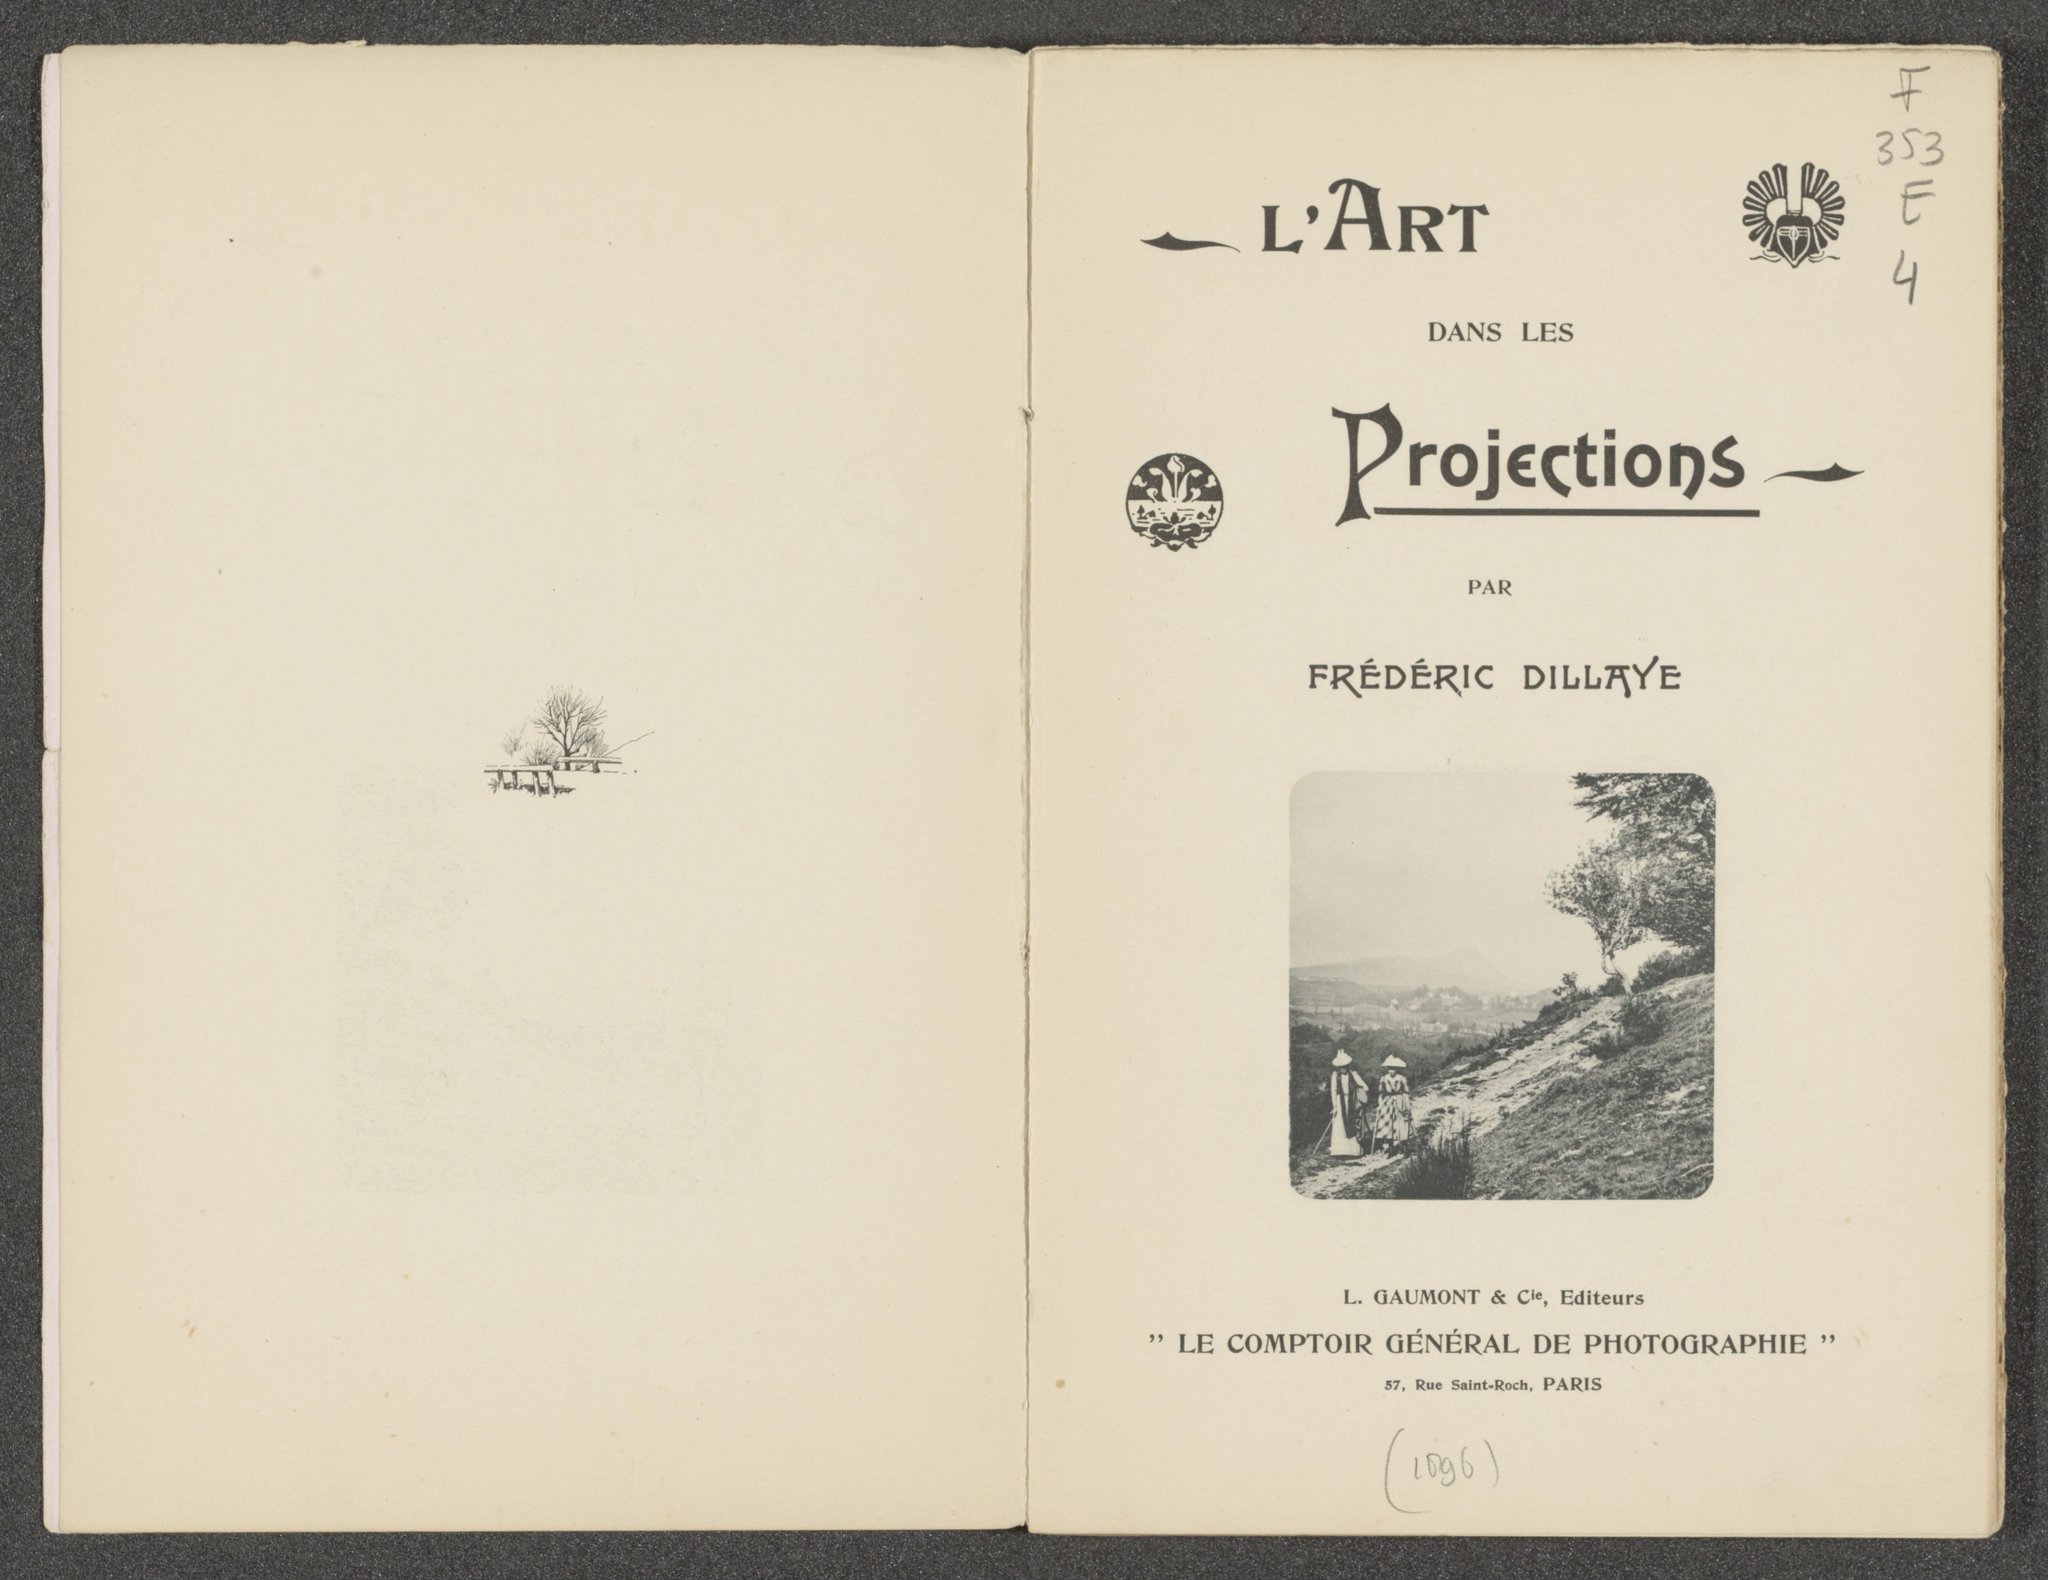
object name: book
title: L'art dans les projections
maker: frédéric dillaye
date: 1896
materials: paper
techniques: photograph, printing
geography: paris